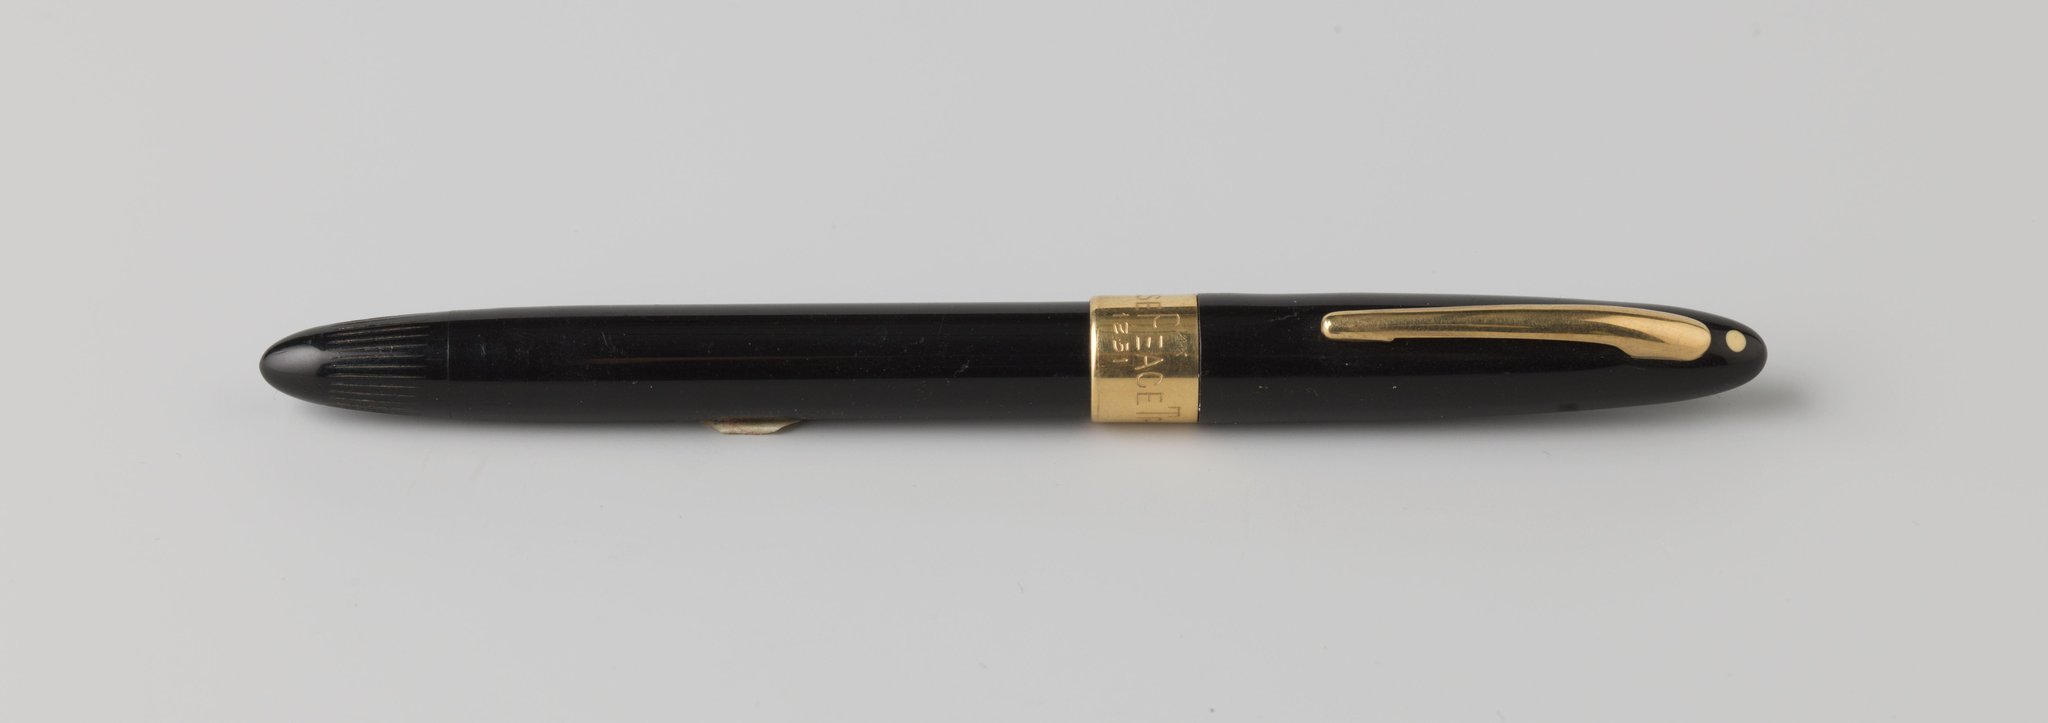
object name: fountain pen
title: Pen 'Japanese Peace Treaty 1951'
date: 1951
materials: gold, plastic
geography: fort madison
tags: politician, japan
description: Zwart vulpen met gouden klipje, pen en onderkant dop, waarin tekst is gegraveerd. Opschrift: 'Japanese Peace Treaty 1951'. Gemerkt: Sheaffer's Made in USA 14K.